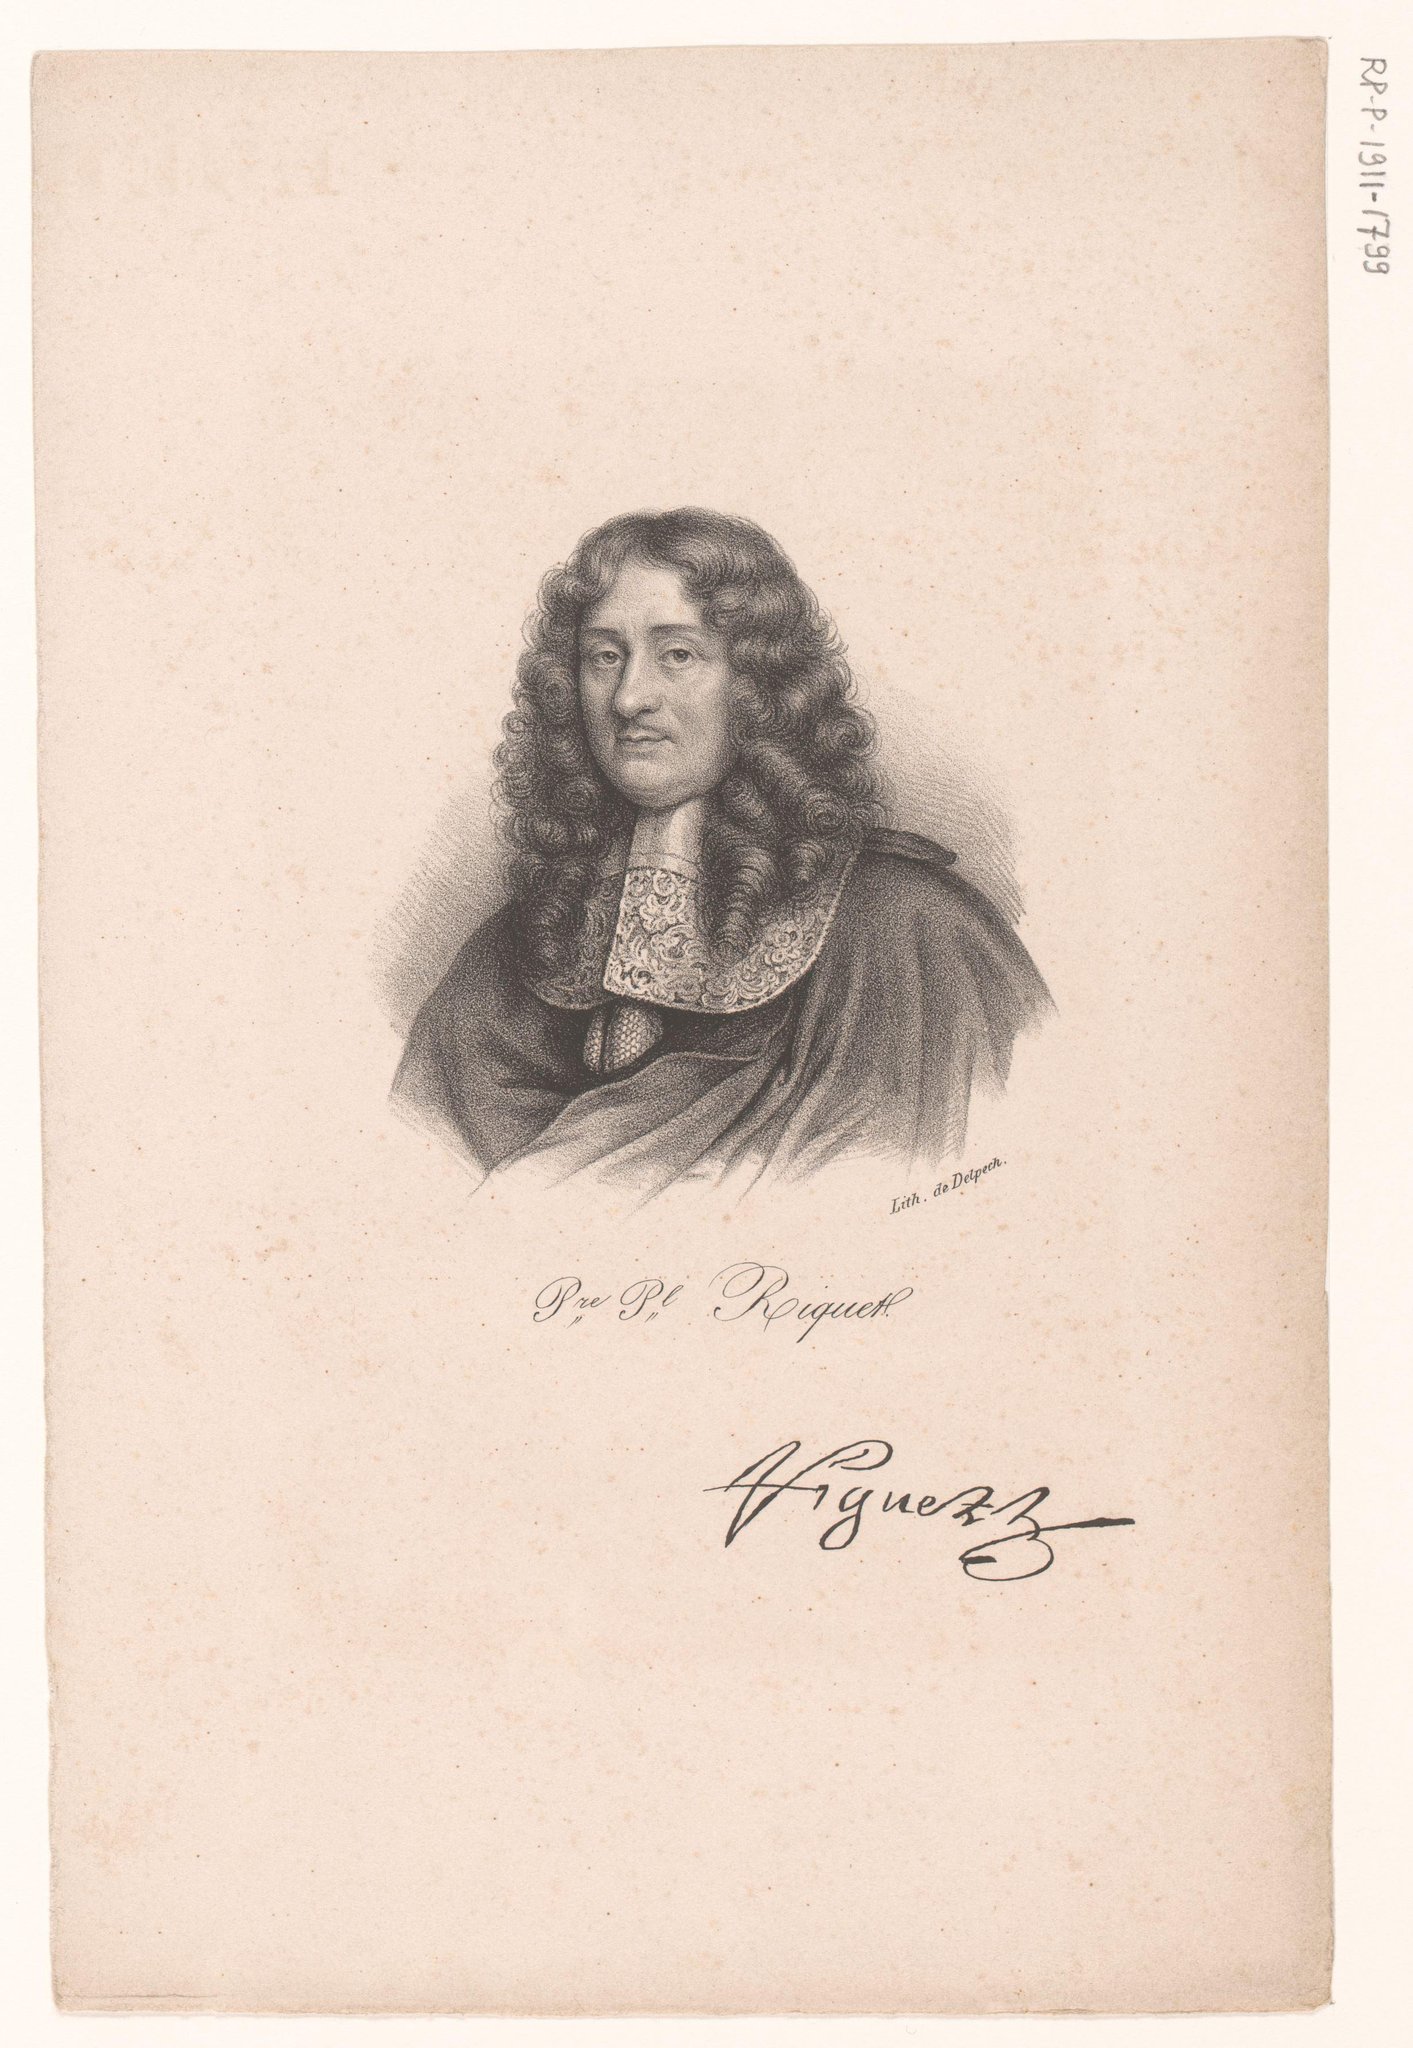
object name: print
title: Portret van Pierre-Paul Riquet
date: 1818-1842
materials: paper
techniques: lithograph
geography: paris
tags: historical persons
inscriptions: collector's mark: Lugt 2228a